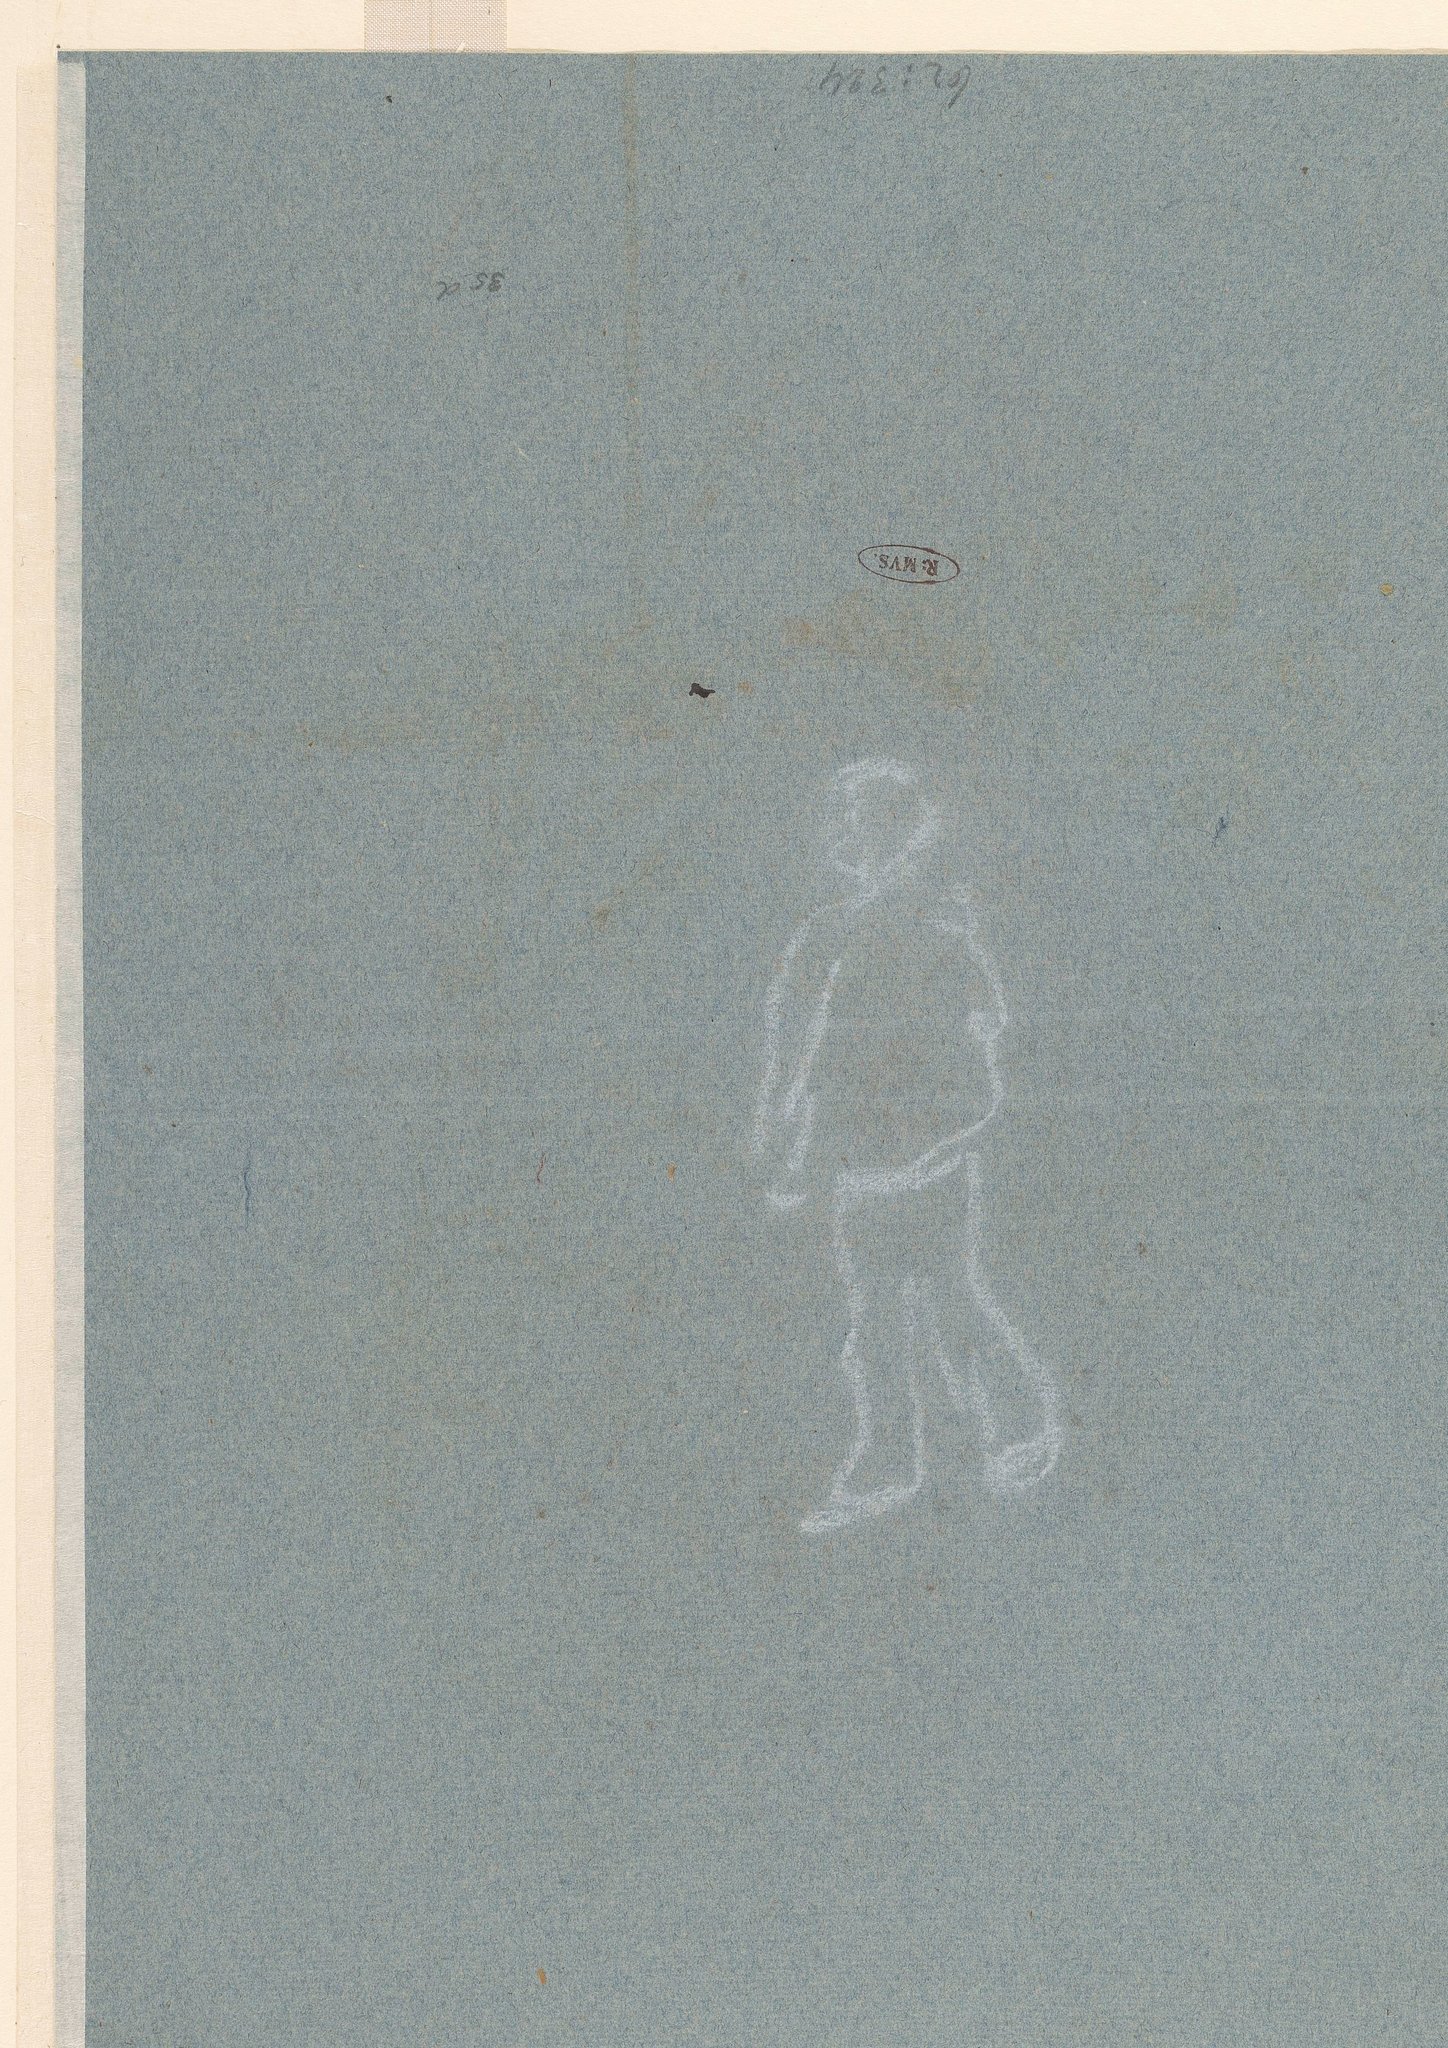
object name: drawing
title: Lopend persoon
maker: jan veth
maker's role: designer, draughtsman, painter, print maker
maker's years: 1864-1925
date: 1874-1925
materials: chalk, paper